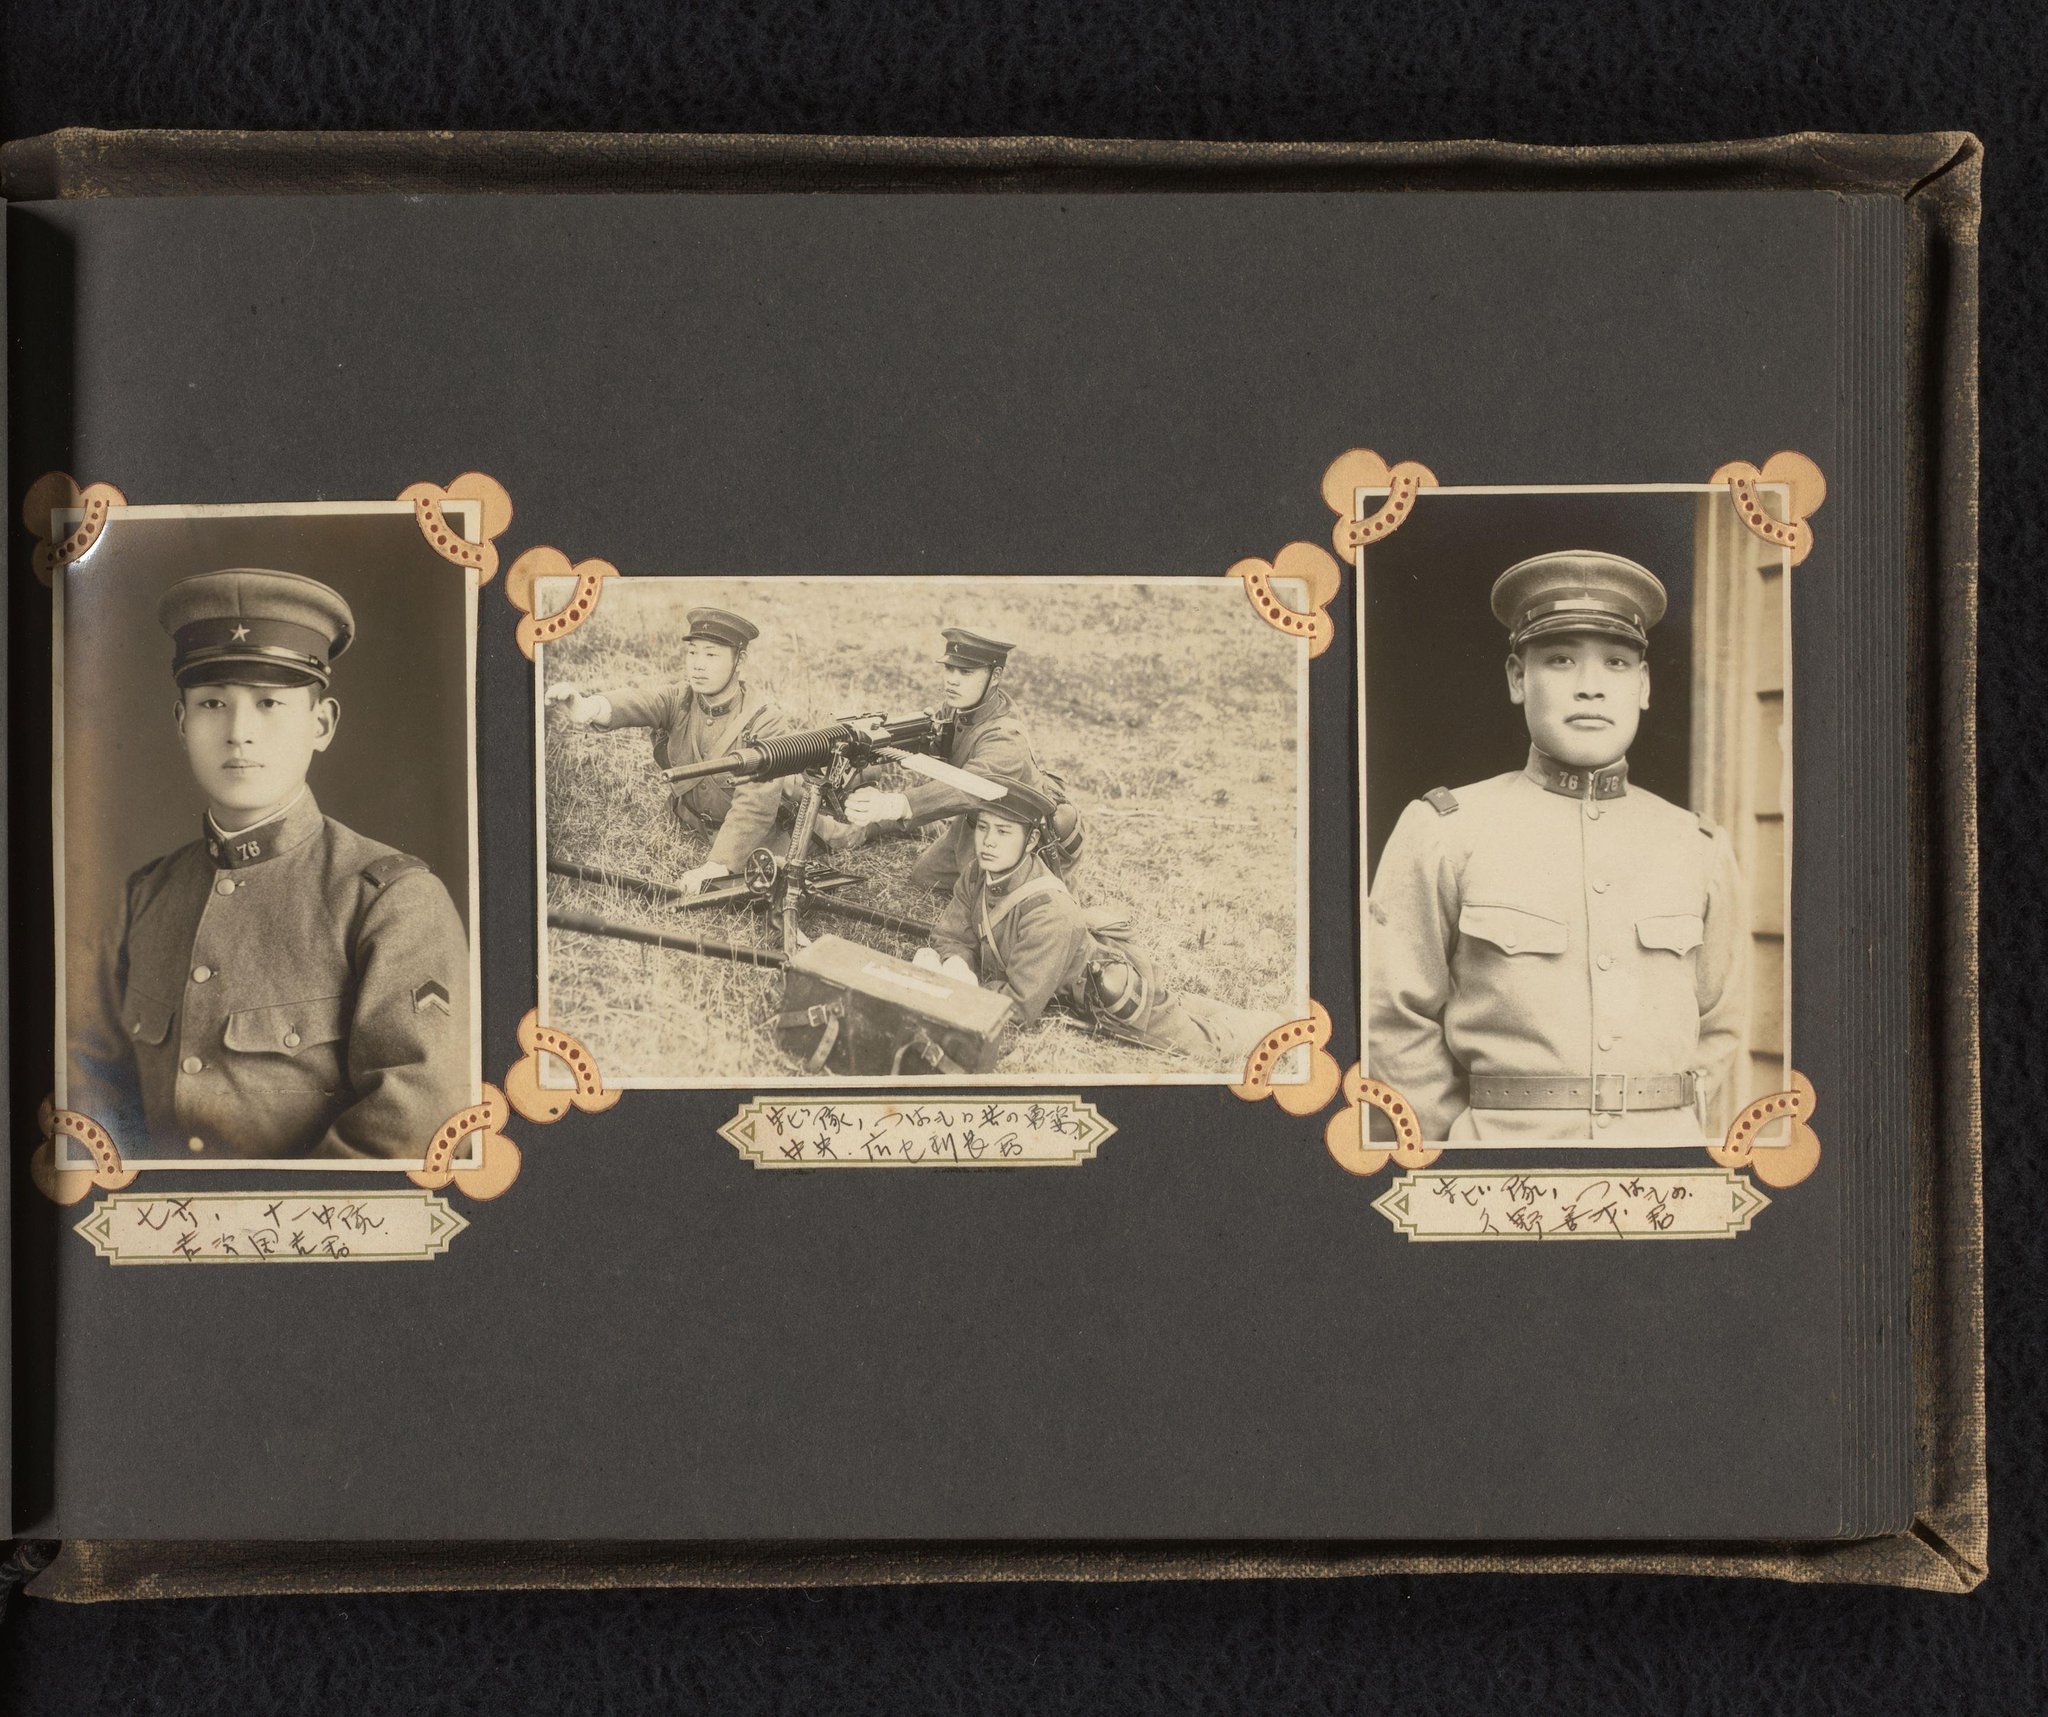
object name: photograph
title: Drie portretten van onbekende Japanse soldaten, in het midden tijdens militaire actie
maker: Anonymous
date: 1930-1940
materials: paper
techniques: gelatin silver print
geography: korea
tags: anonymous historical person portrayed, firearms: rifle, the soldier; the soldier's life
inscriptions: inscription: ‘[...]’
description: Deze foto's zijn onderdeel van een album.